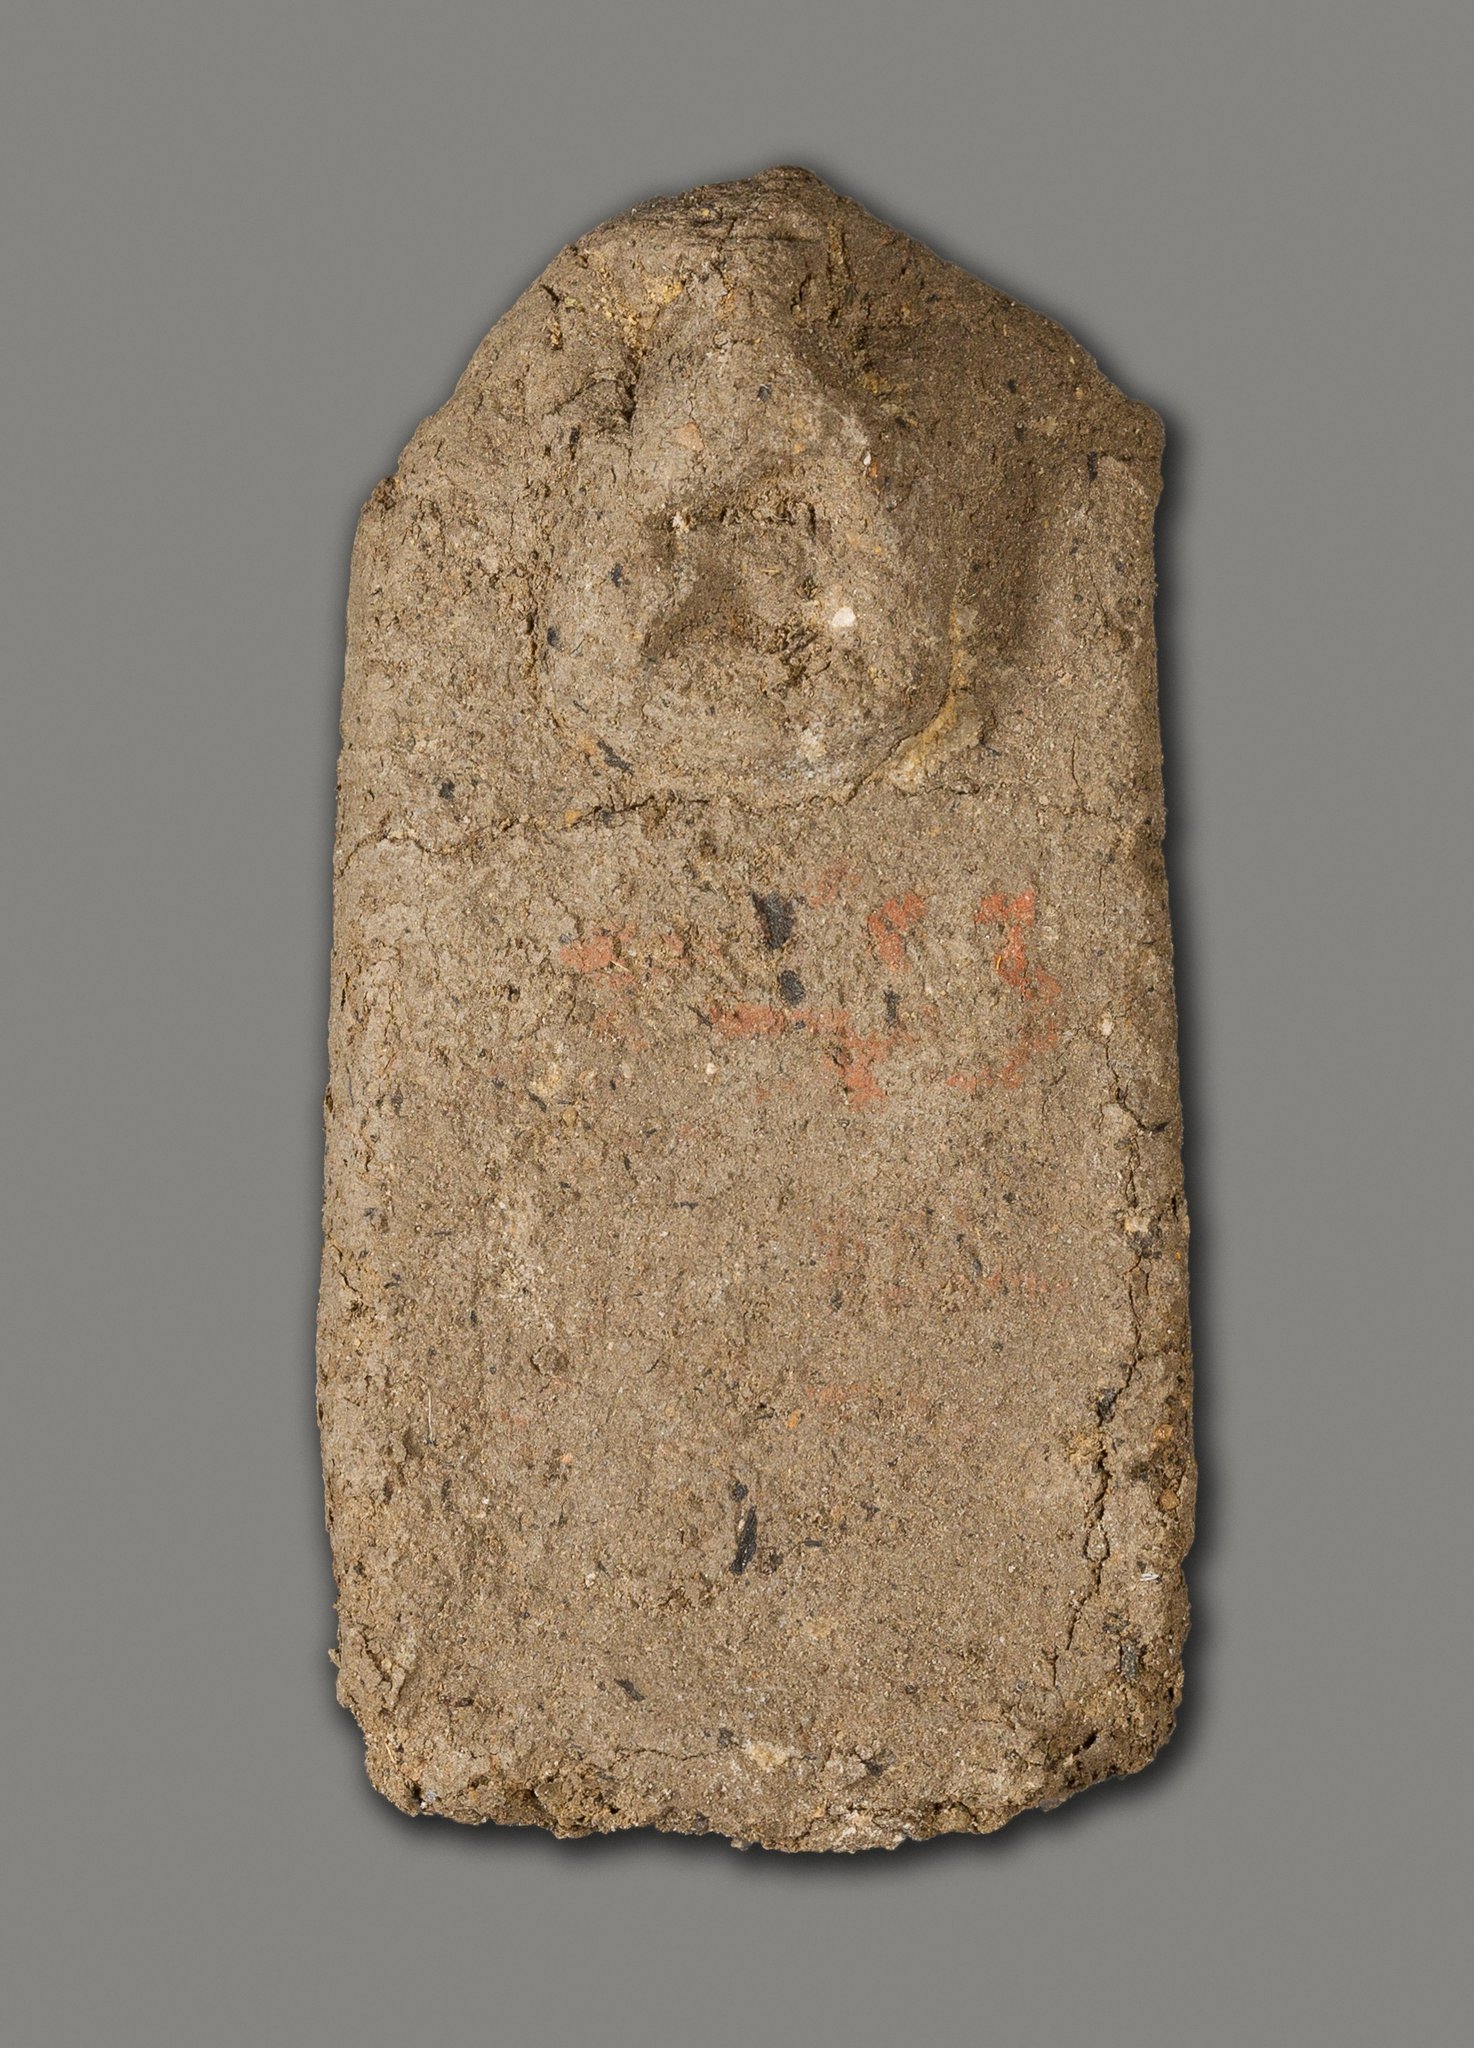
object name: figure, magical, execration, tablet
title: Magical Figure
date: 1802-1550 BCE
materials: clay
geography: egypt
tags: faces